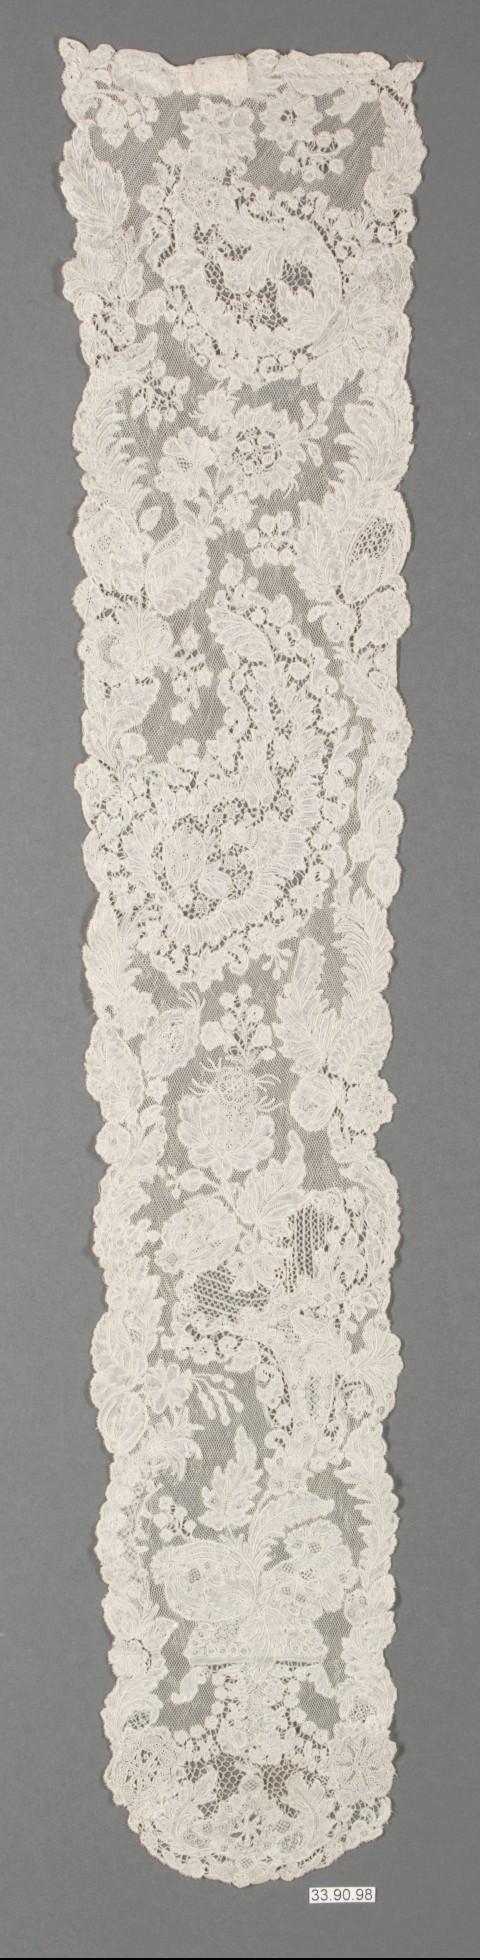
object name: lappet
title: Lappet (one of a pair)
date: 1701-1800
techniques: lace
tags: flowers